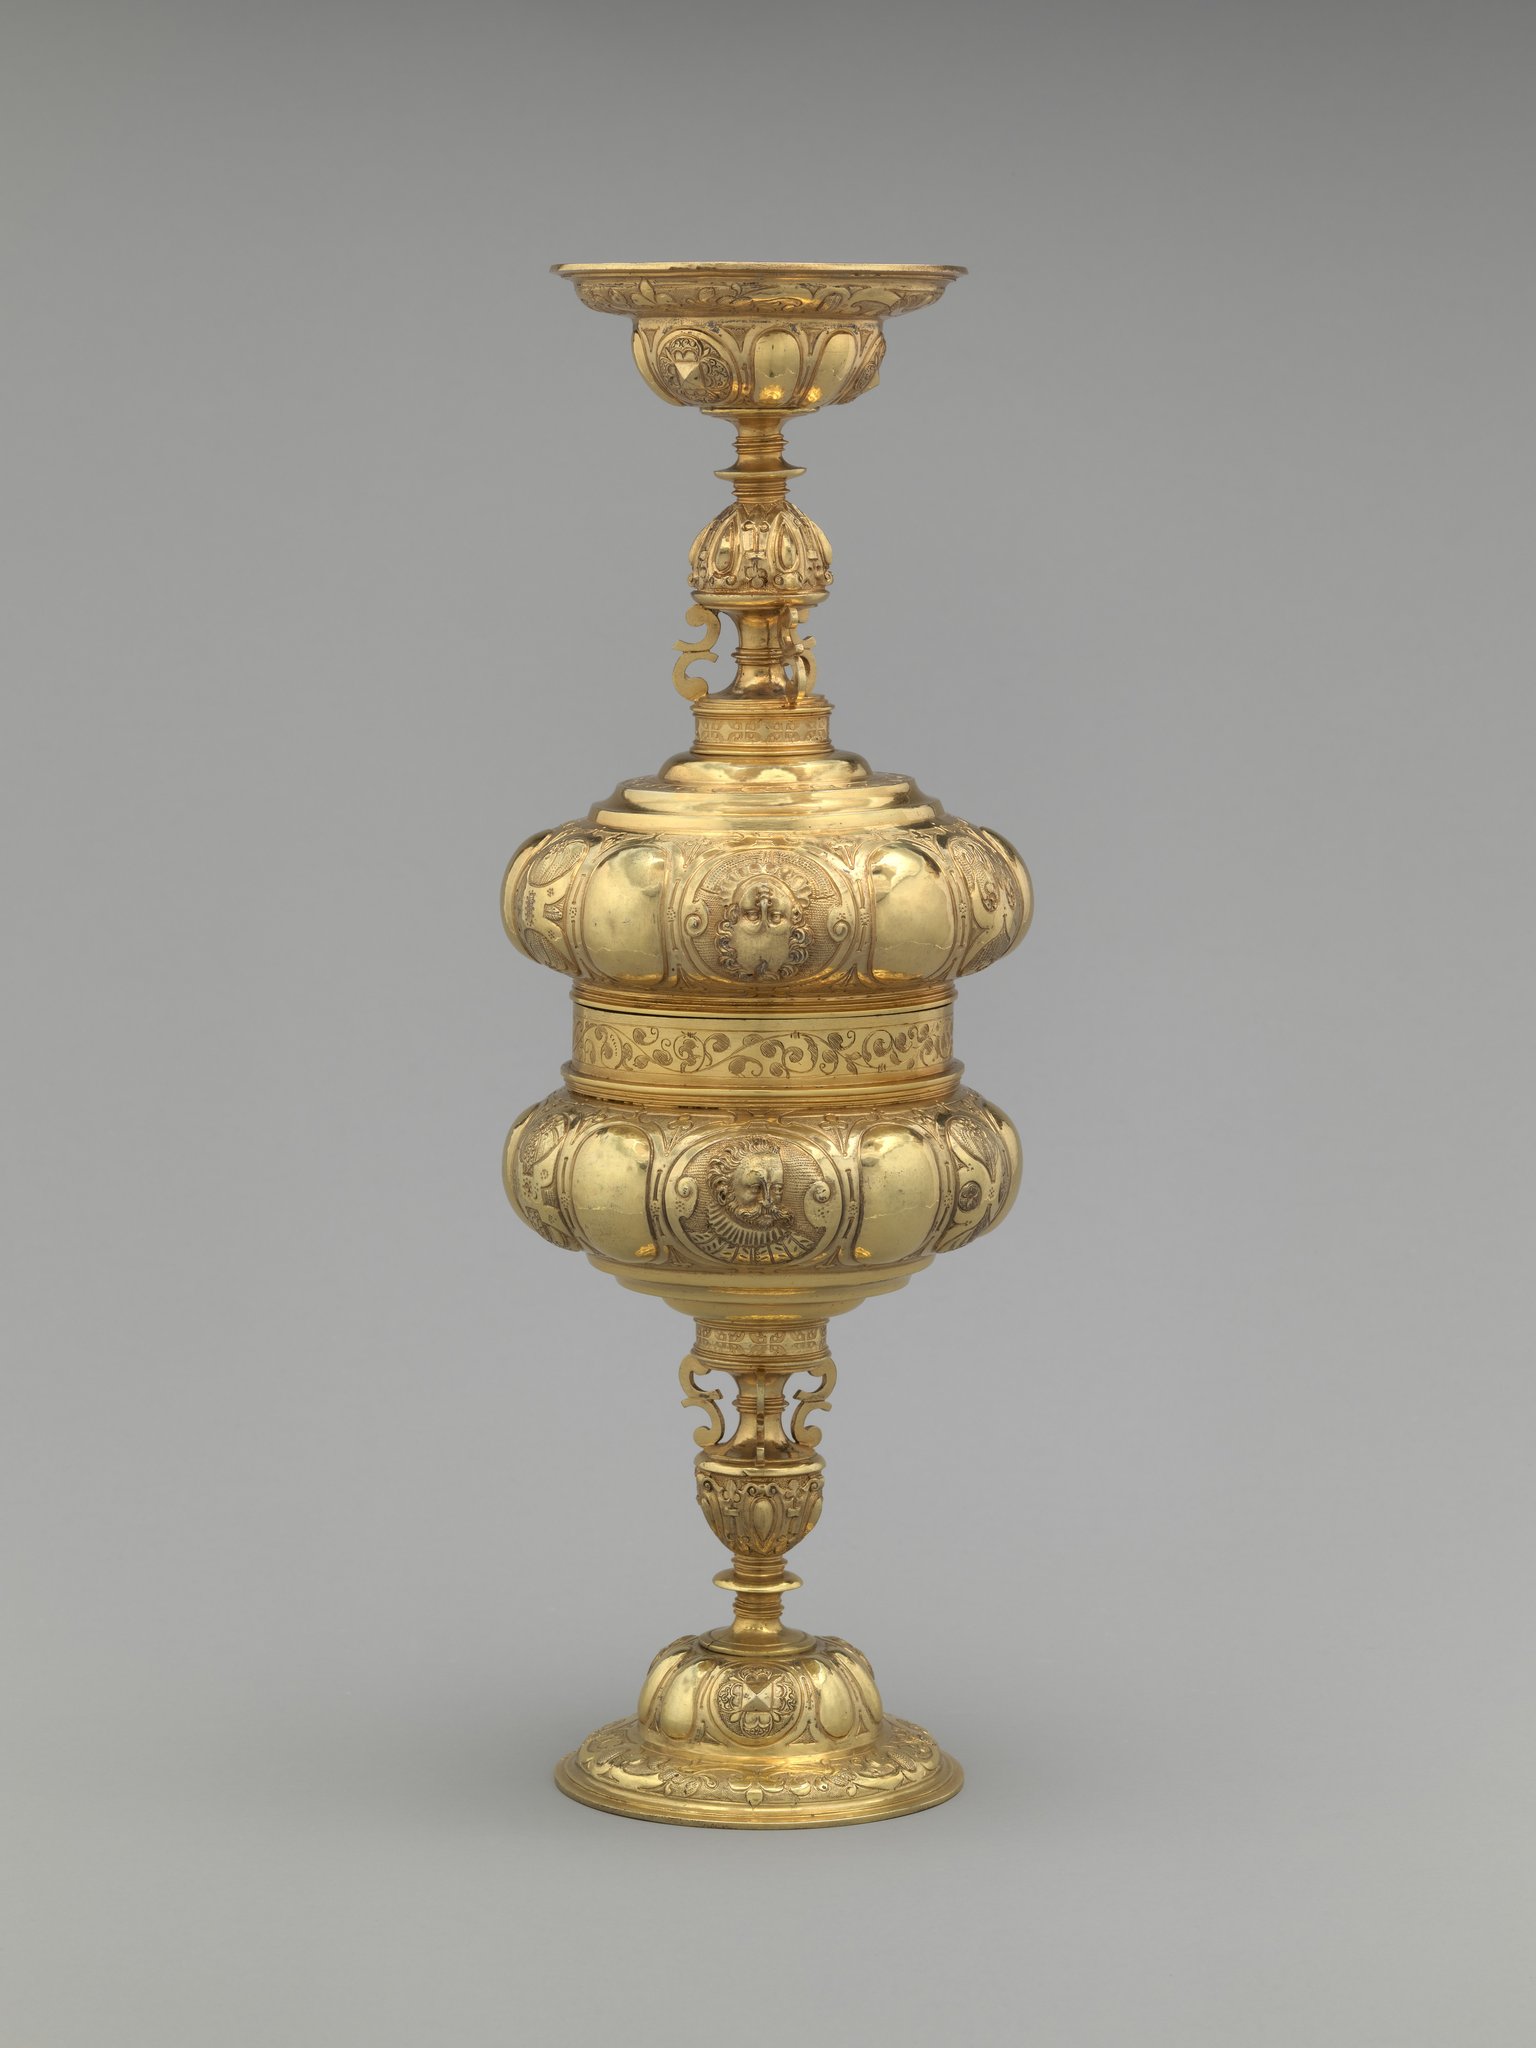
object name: double standing cup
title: Two double standing cups (trussing cups)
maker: simon pissinger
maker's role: maker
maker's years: 1582-1609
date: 1600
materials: gilt silver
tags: men,portraits